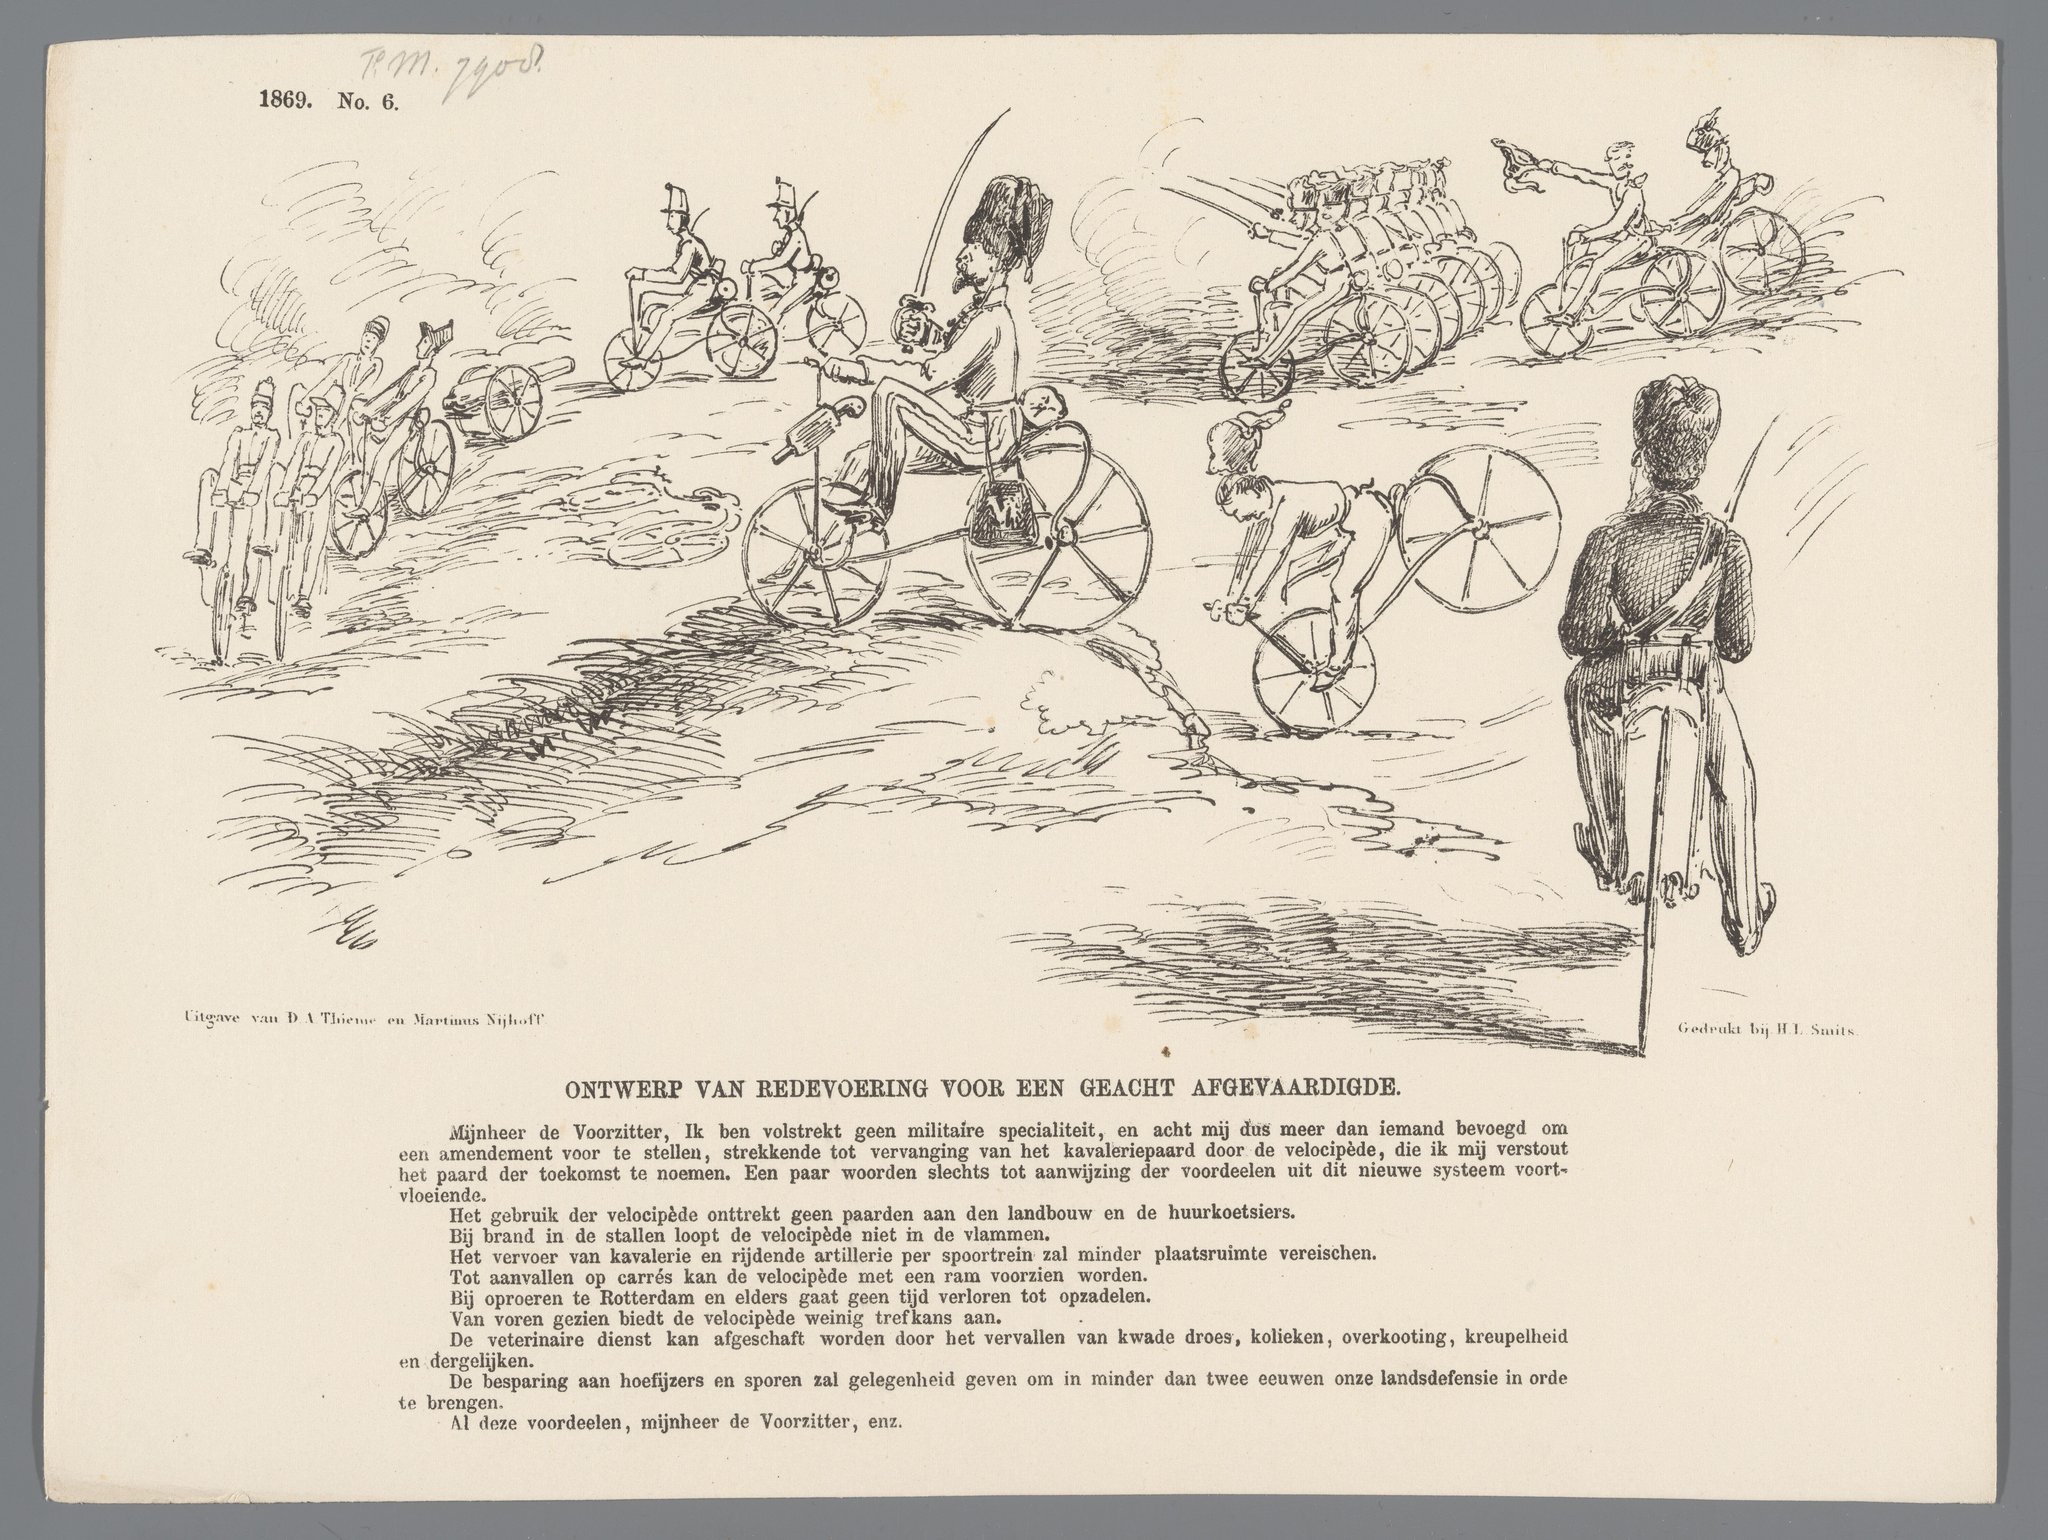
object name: cartoon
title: Ontwerp van redevoering voor een geacht afgevaardigde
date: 1869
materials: paper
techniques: lithograph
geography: the hague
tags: antique types of bicycles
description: Spotprent op de heersende velocipèdewoede: huzaren en infanterie rijdend op fietsen. Plaat verschenen bij het weekblad De Nederlandsche Spectator, nr. 6, 1869.